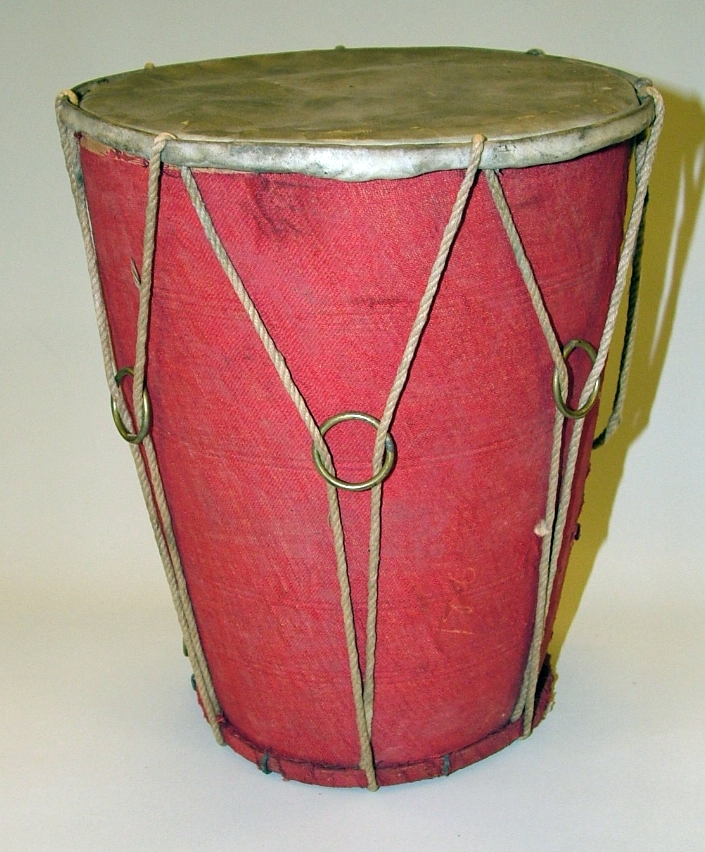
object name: drum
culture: indian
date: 1801-1900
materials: textile, cord, metal, wood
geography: india